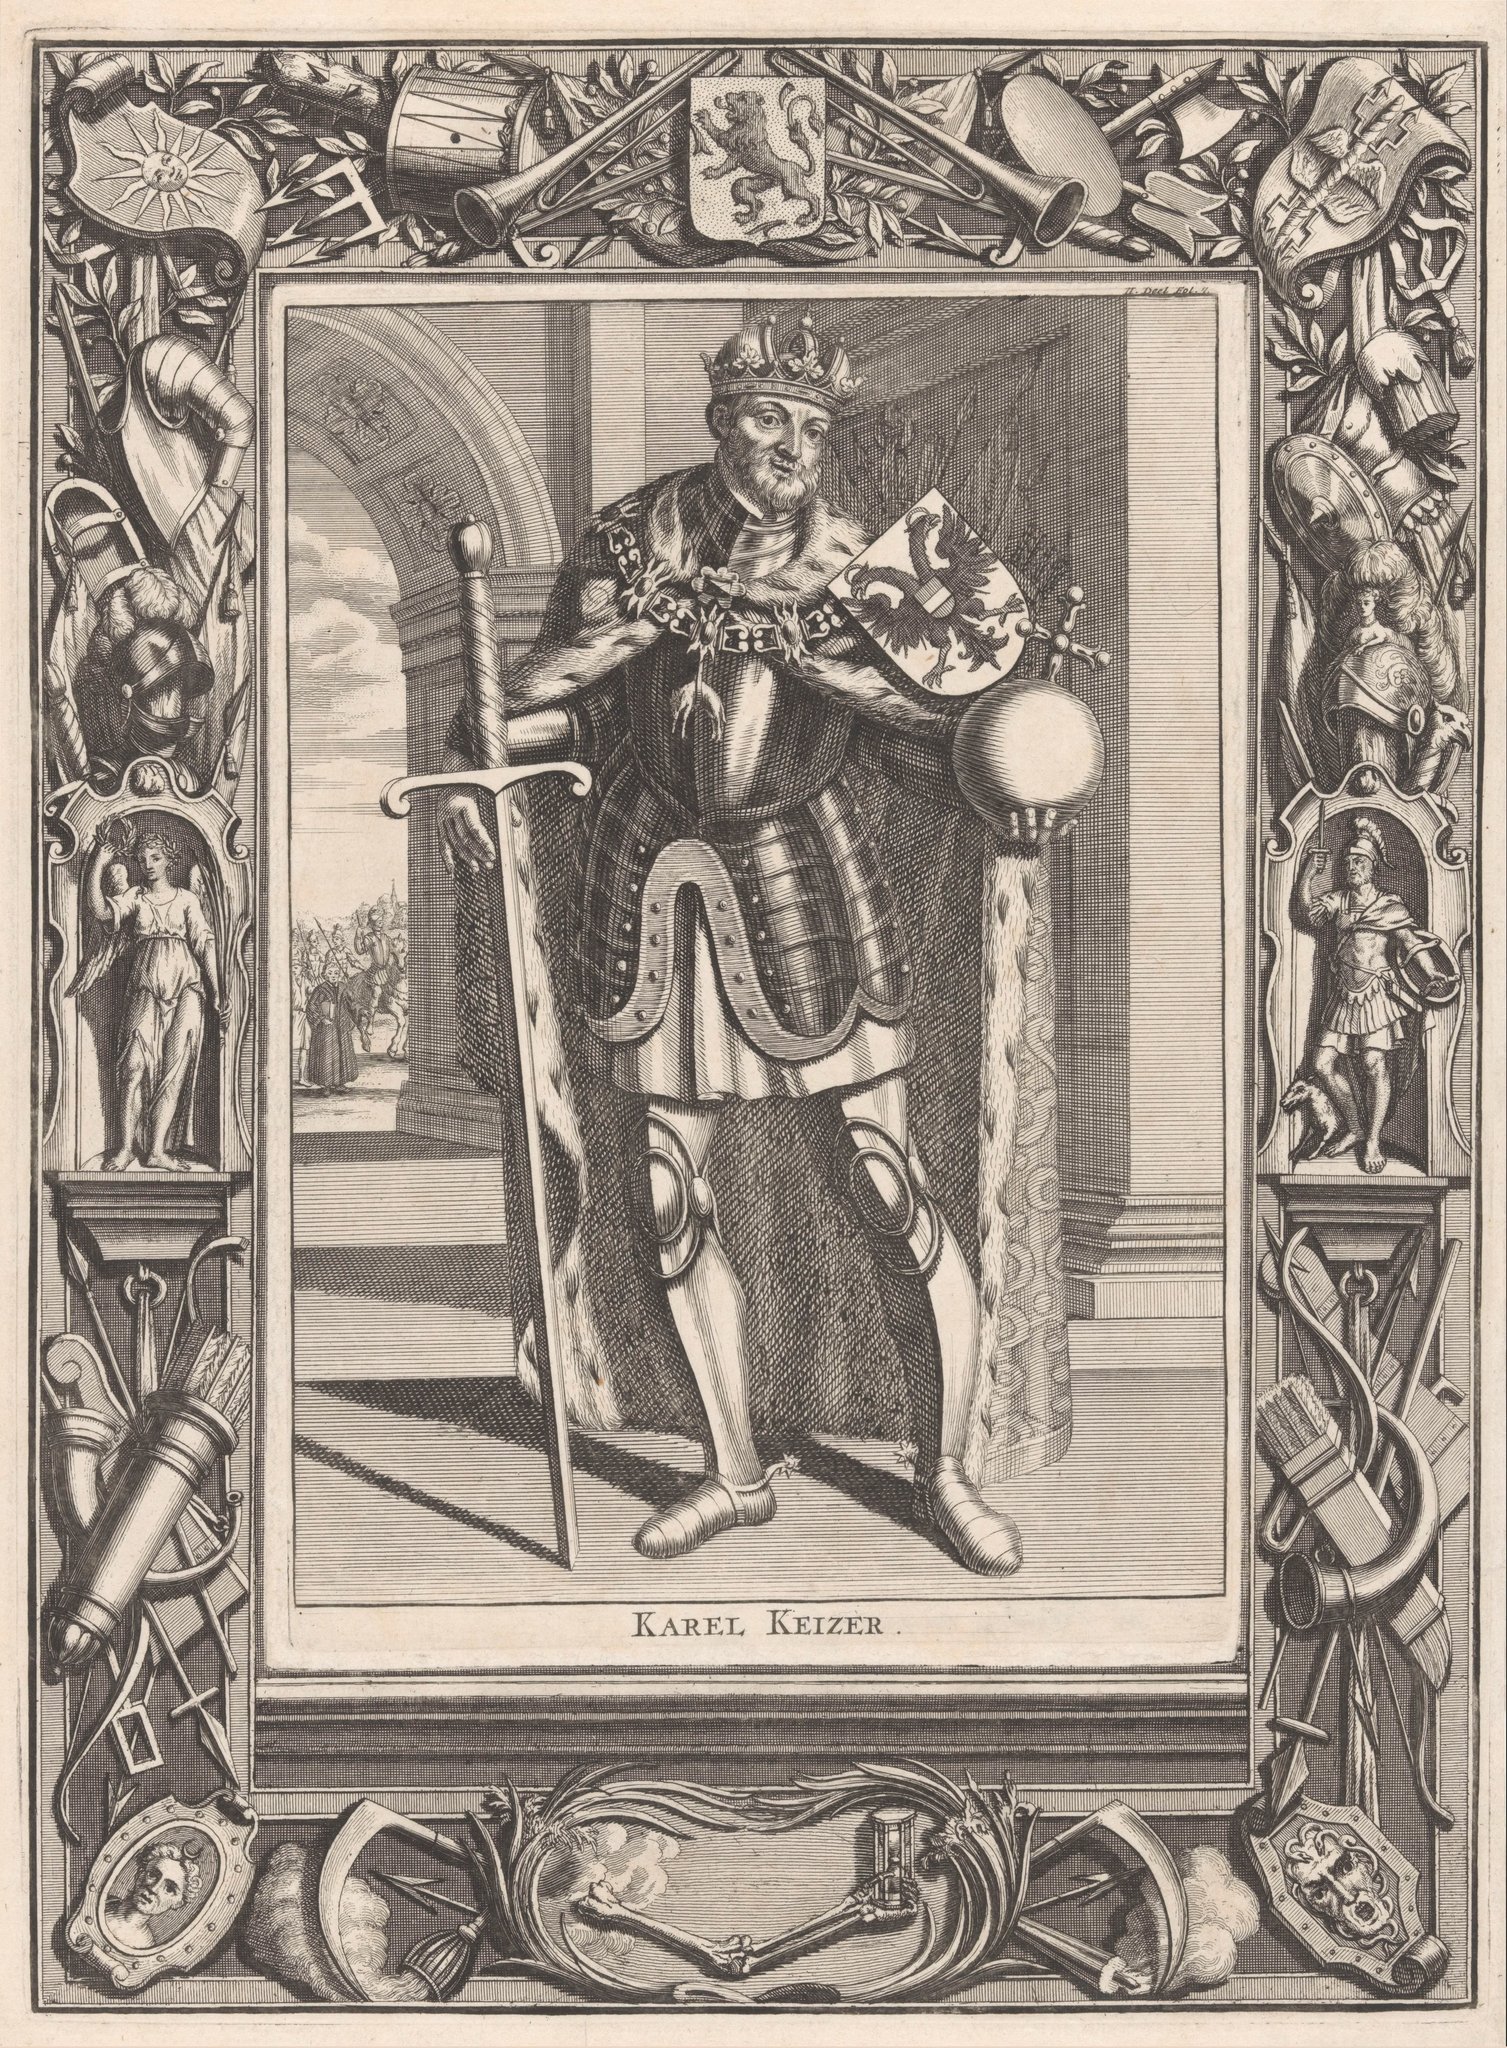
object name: print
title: Portret van keizer Karel V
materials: paper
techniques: engraving, etching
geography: leeuwarden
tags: ghent, charles v (holy roman emperor and king of spain), historical person (...) - historical person (...) portrayed alone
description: Portret van Karel van Habsburg ten voeten uit, met wapenschild op de linkerschouder en een rijksappel in de linkerhand. Rondom een ornamentele omlijsting met wapentrofeeën en de goden Victoria en Mars.